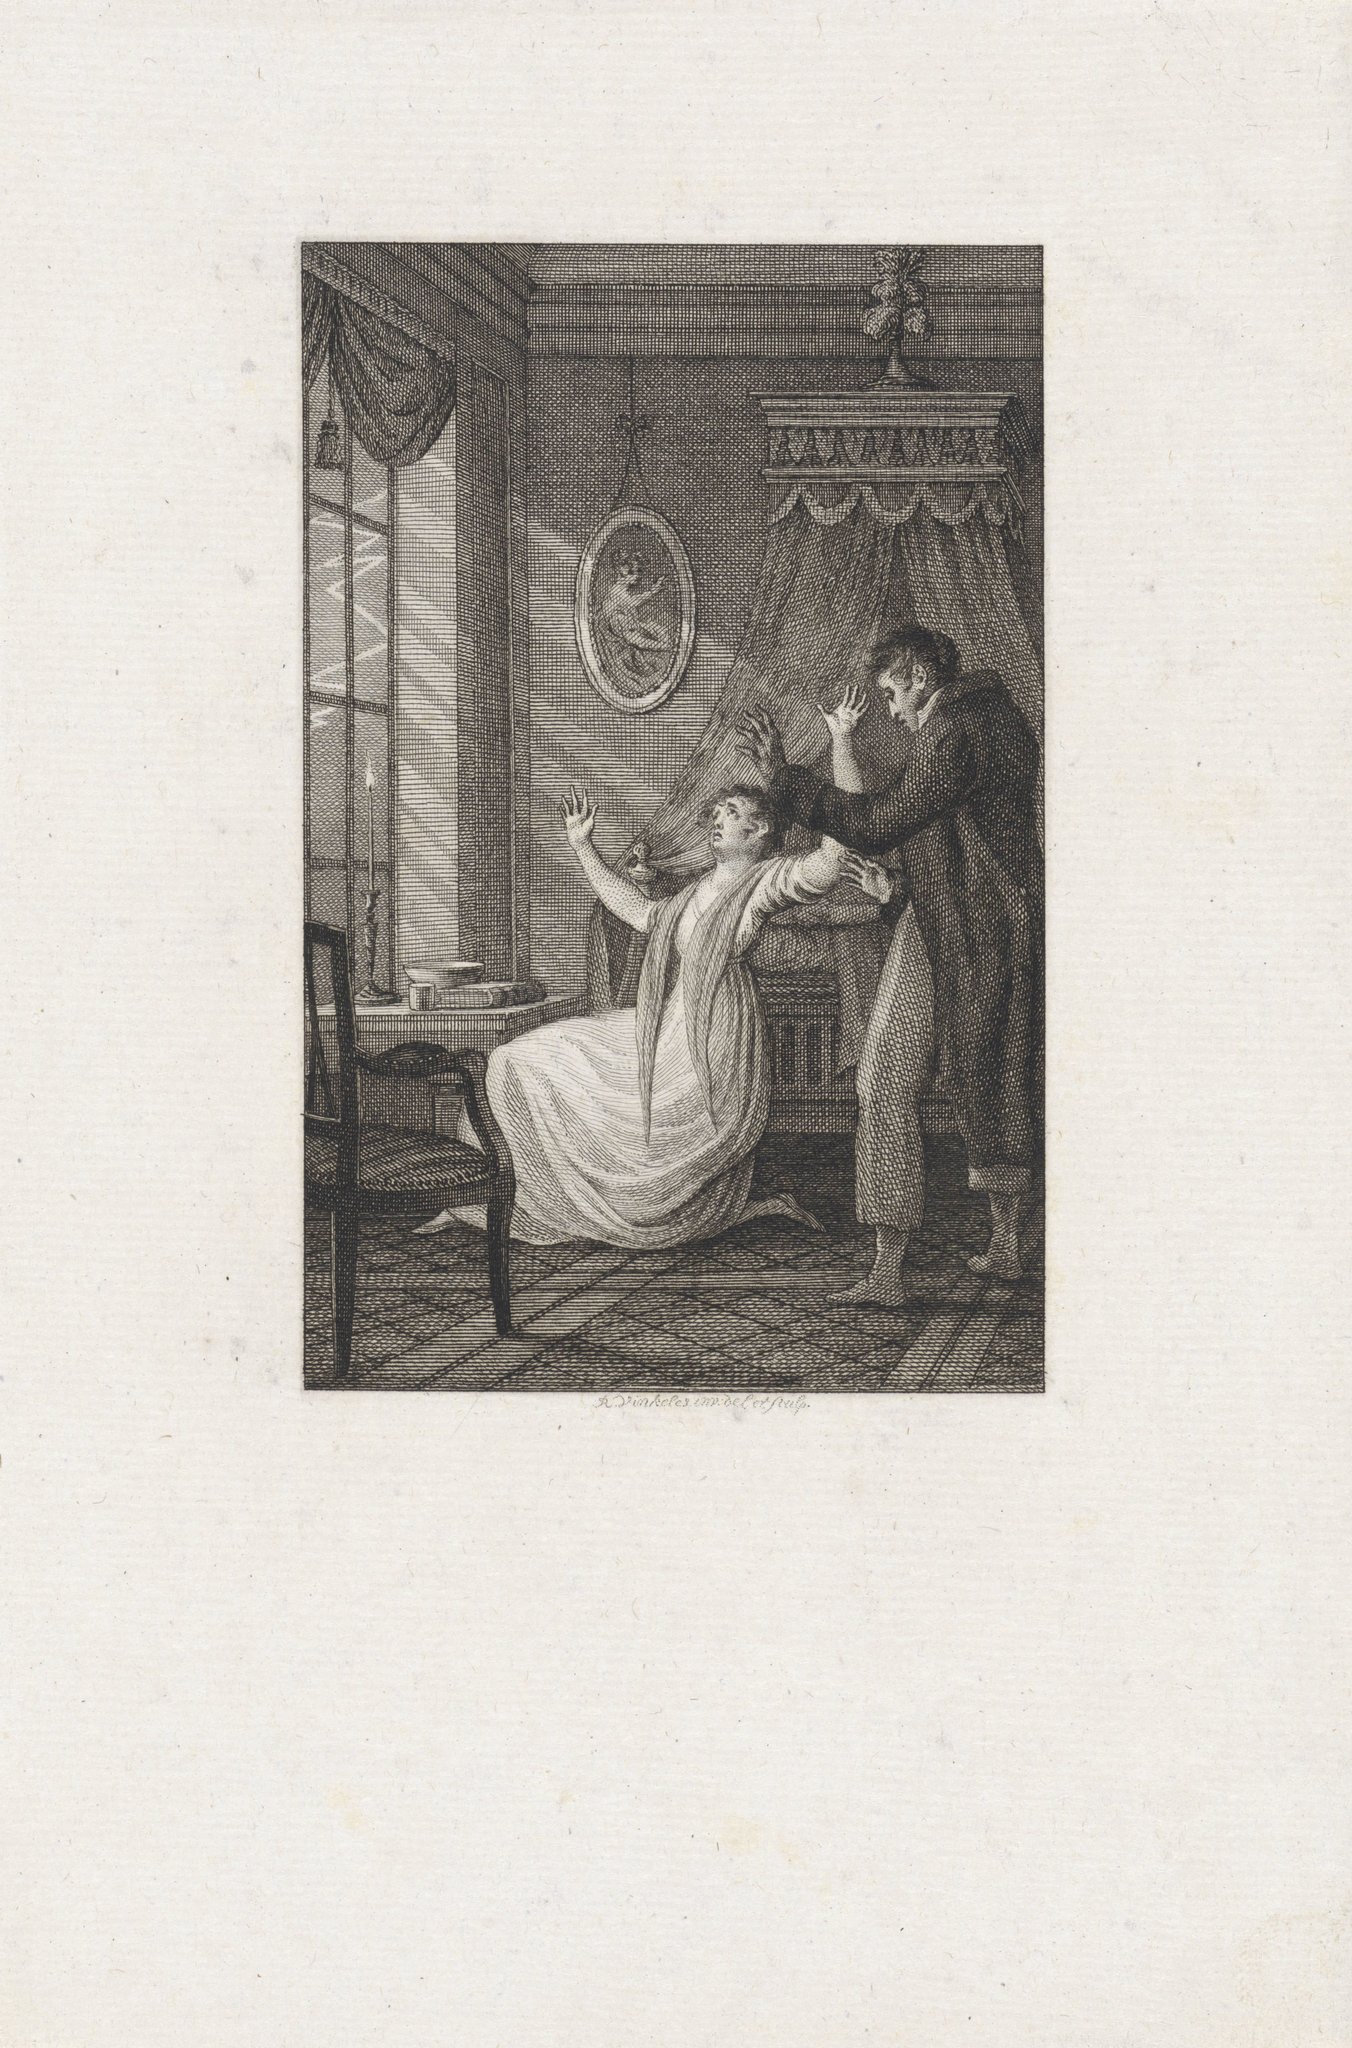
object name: print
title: Paar schrikt van een bliksemschicht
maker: reinier vinkeles (i)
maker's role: draughtsman, print maker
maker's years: 1741-1816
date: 1751-1816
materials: paper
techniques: engraving, etching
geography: amsterdam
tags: candle, bed, lightning, flash of lightning, thunderbolt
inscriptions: collector's mark: Lugt 2228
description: In een slaapkamer schrikt een paar van een bliksemschicht, bij nacht.